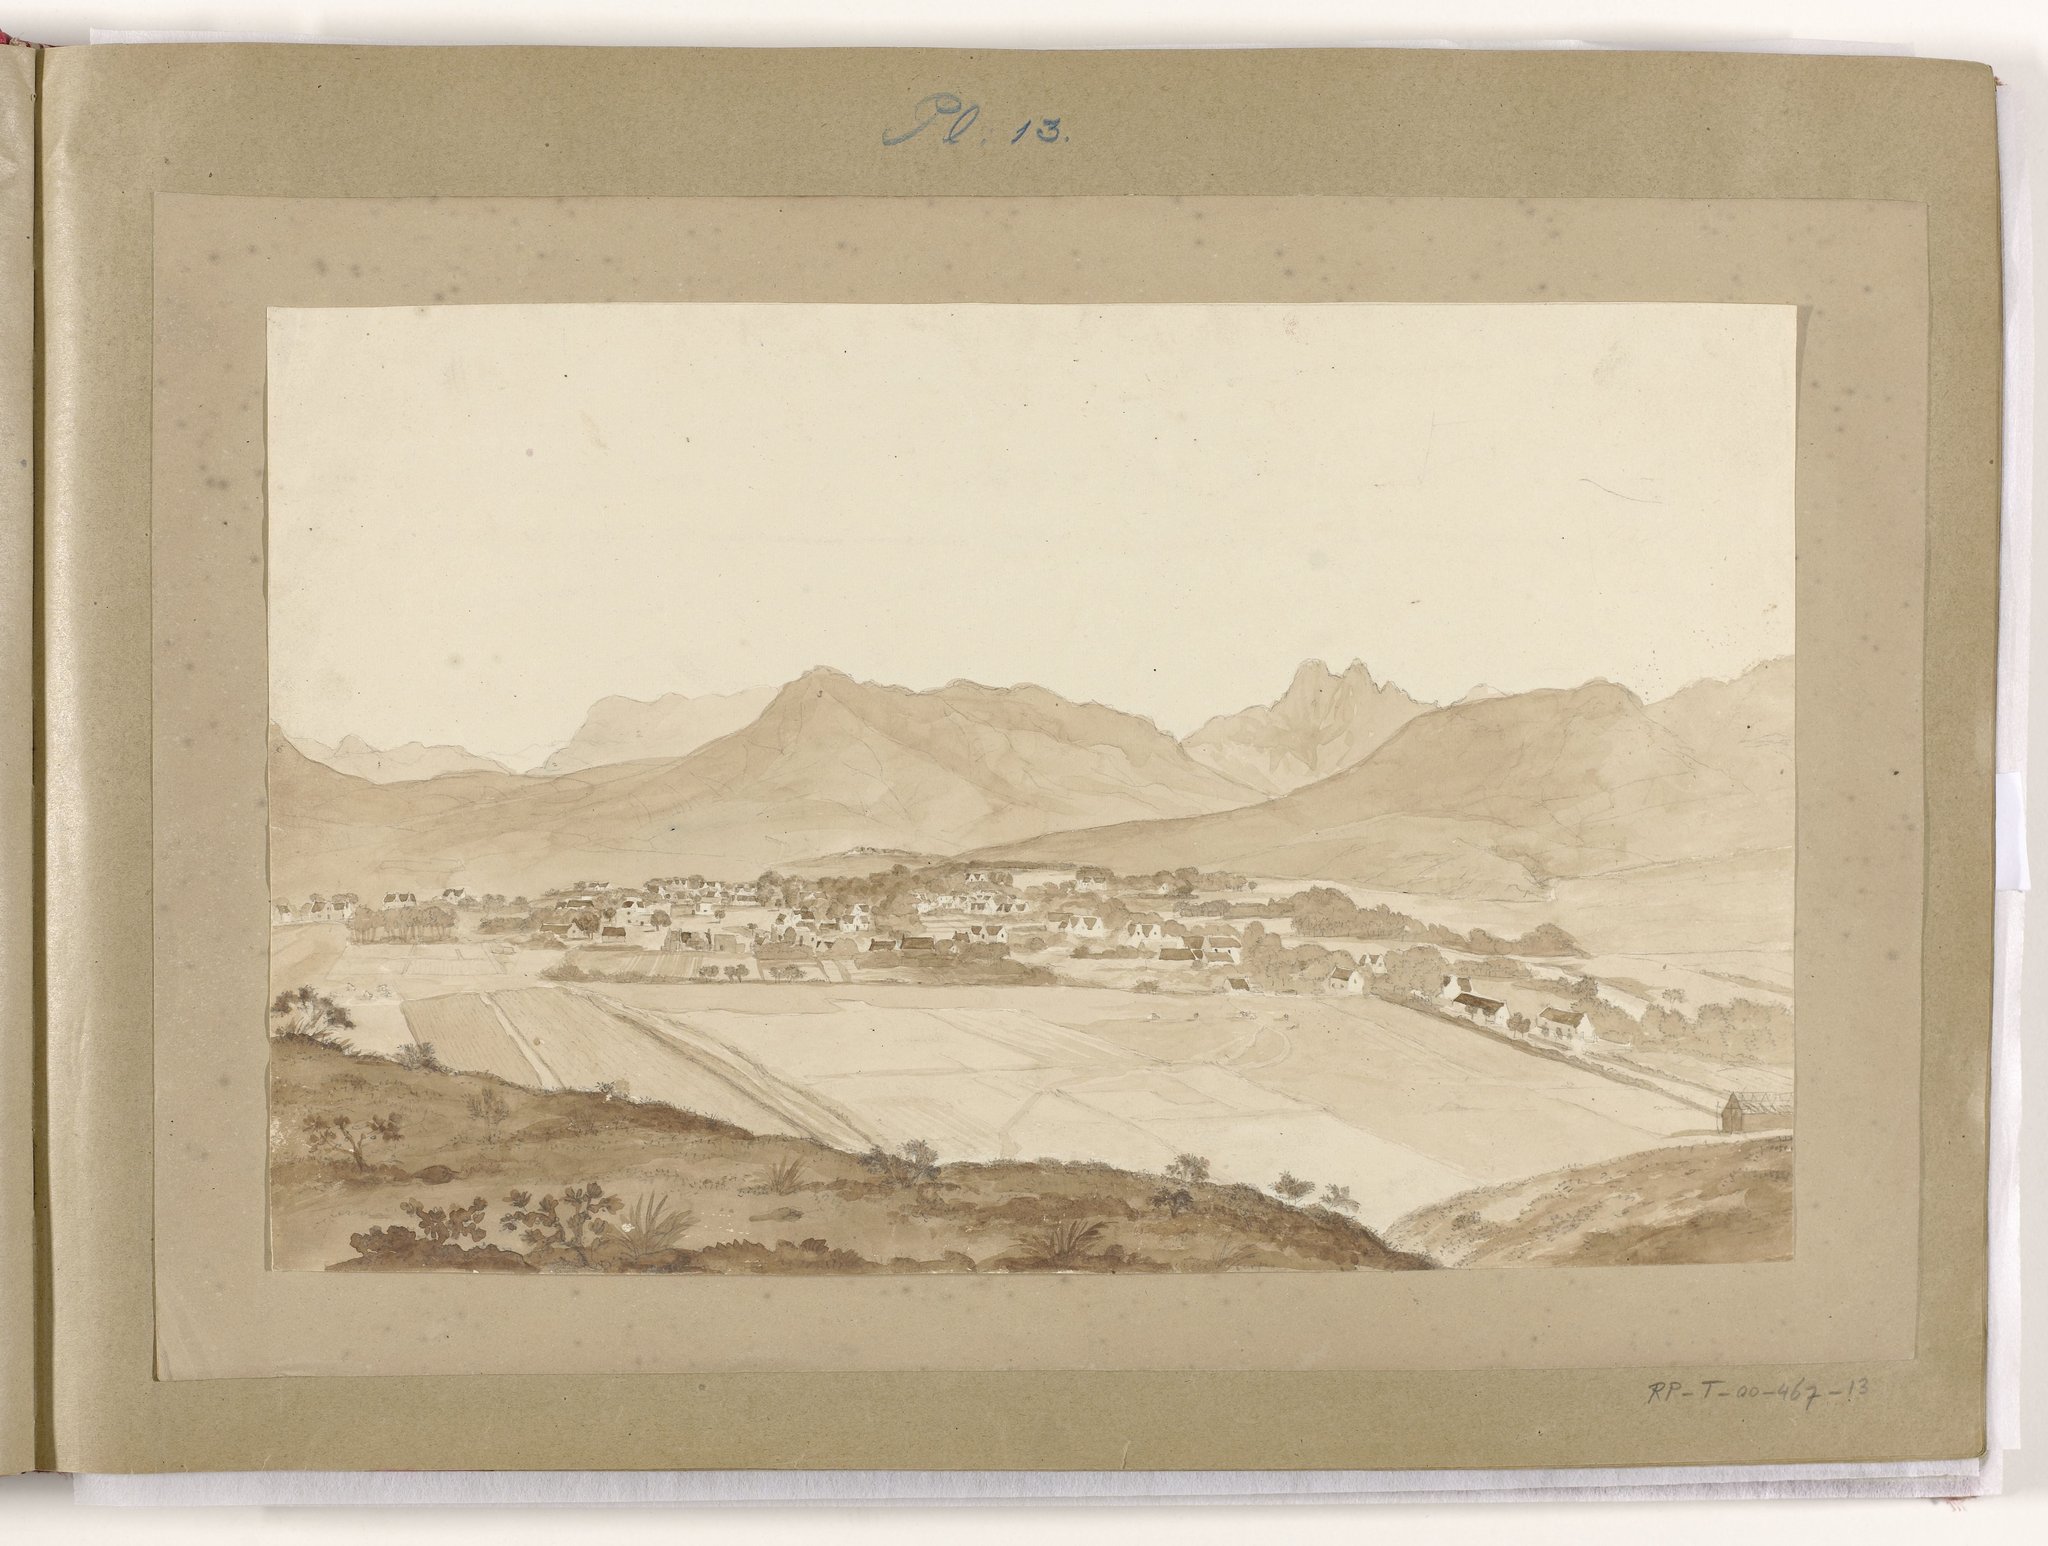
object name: album leaf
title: Gezicht op Stellenbosch, Drakenberg, Simonsberg etc etc Kaap de Goede Hoop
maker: adrianus johannes bik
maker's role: draughtsman, print maker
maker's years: 1790-1872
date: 1816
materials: paper, pencil, pigment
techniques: brush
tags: city-view, and landscape with man-made constructions, mountains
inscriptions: inscription: ‘Gezigt op StellenBosch/ Drakenberg. Simons Berg. & &./ Kaap de goede Hoop/ A.J. Bik fec[i]t 1816’